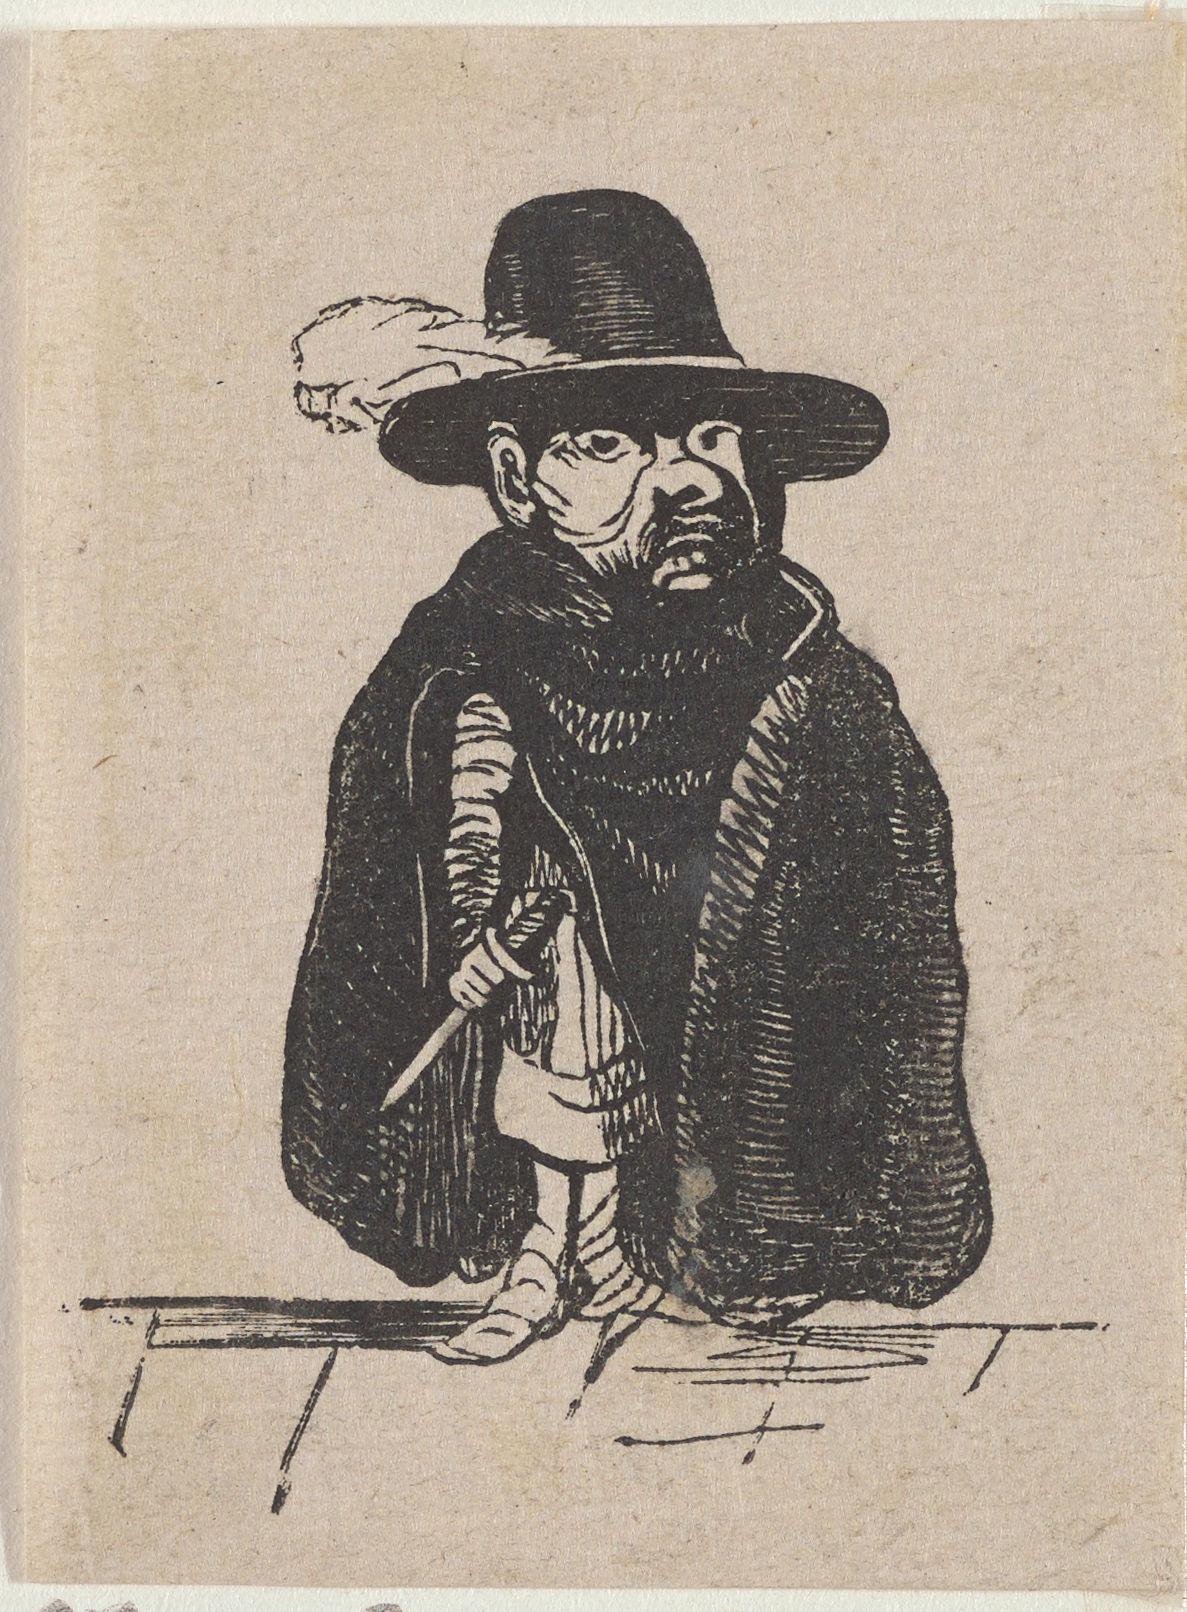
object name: print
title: Karikatuur van een man met een hoed, een cape en een dolk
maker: isaac weissenbruch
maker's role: print maker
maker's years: 1826-1912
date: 1836-1912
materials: paper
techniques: engraving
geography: netherlands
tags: cape (+ men's clothes), hacking and thrusting weapons: dagger, head-gear: hat (+ men's clothes)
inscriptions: collector's mark: Lugt 2228